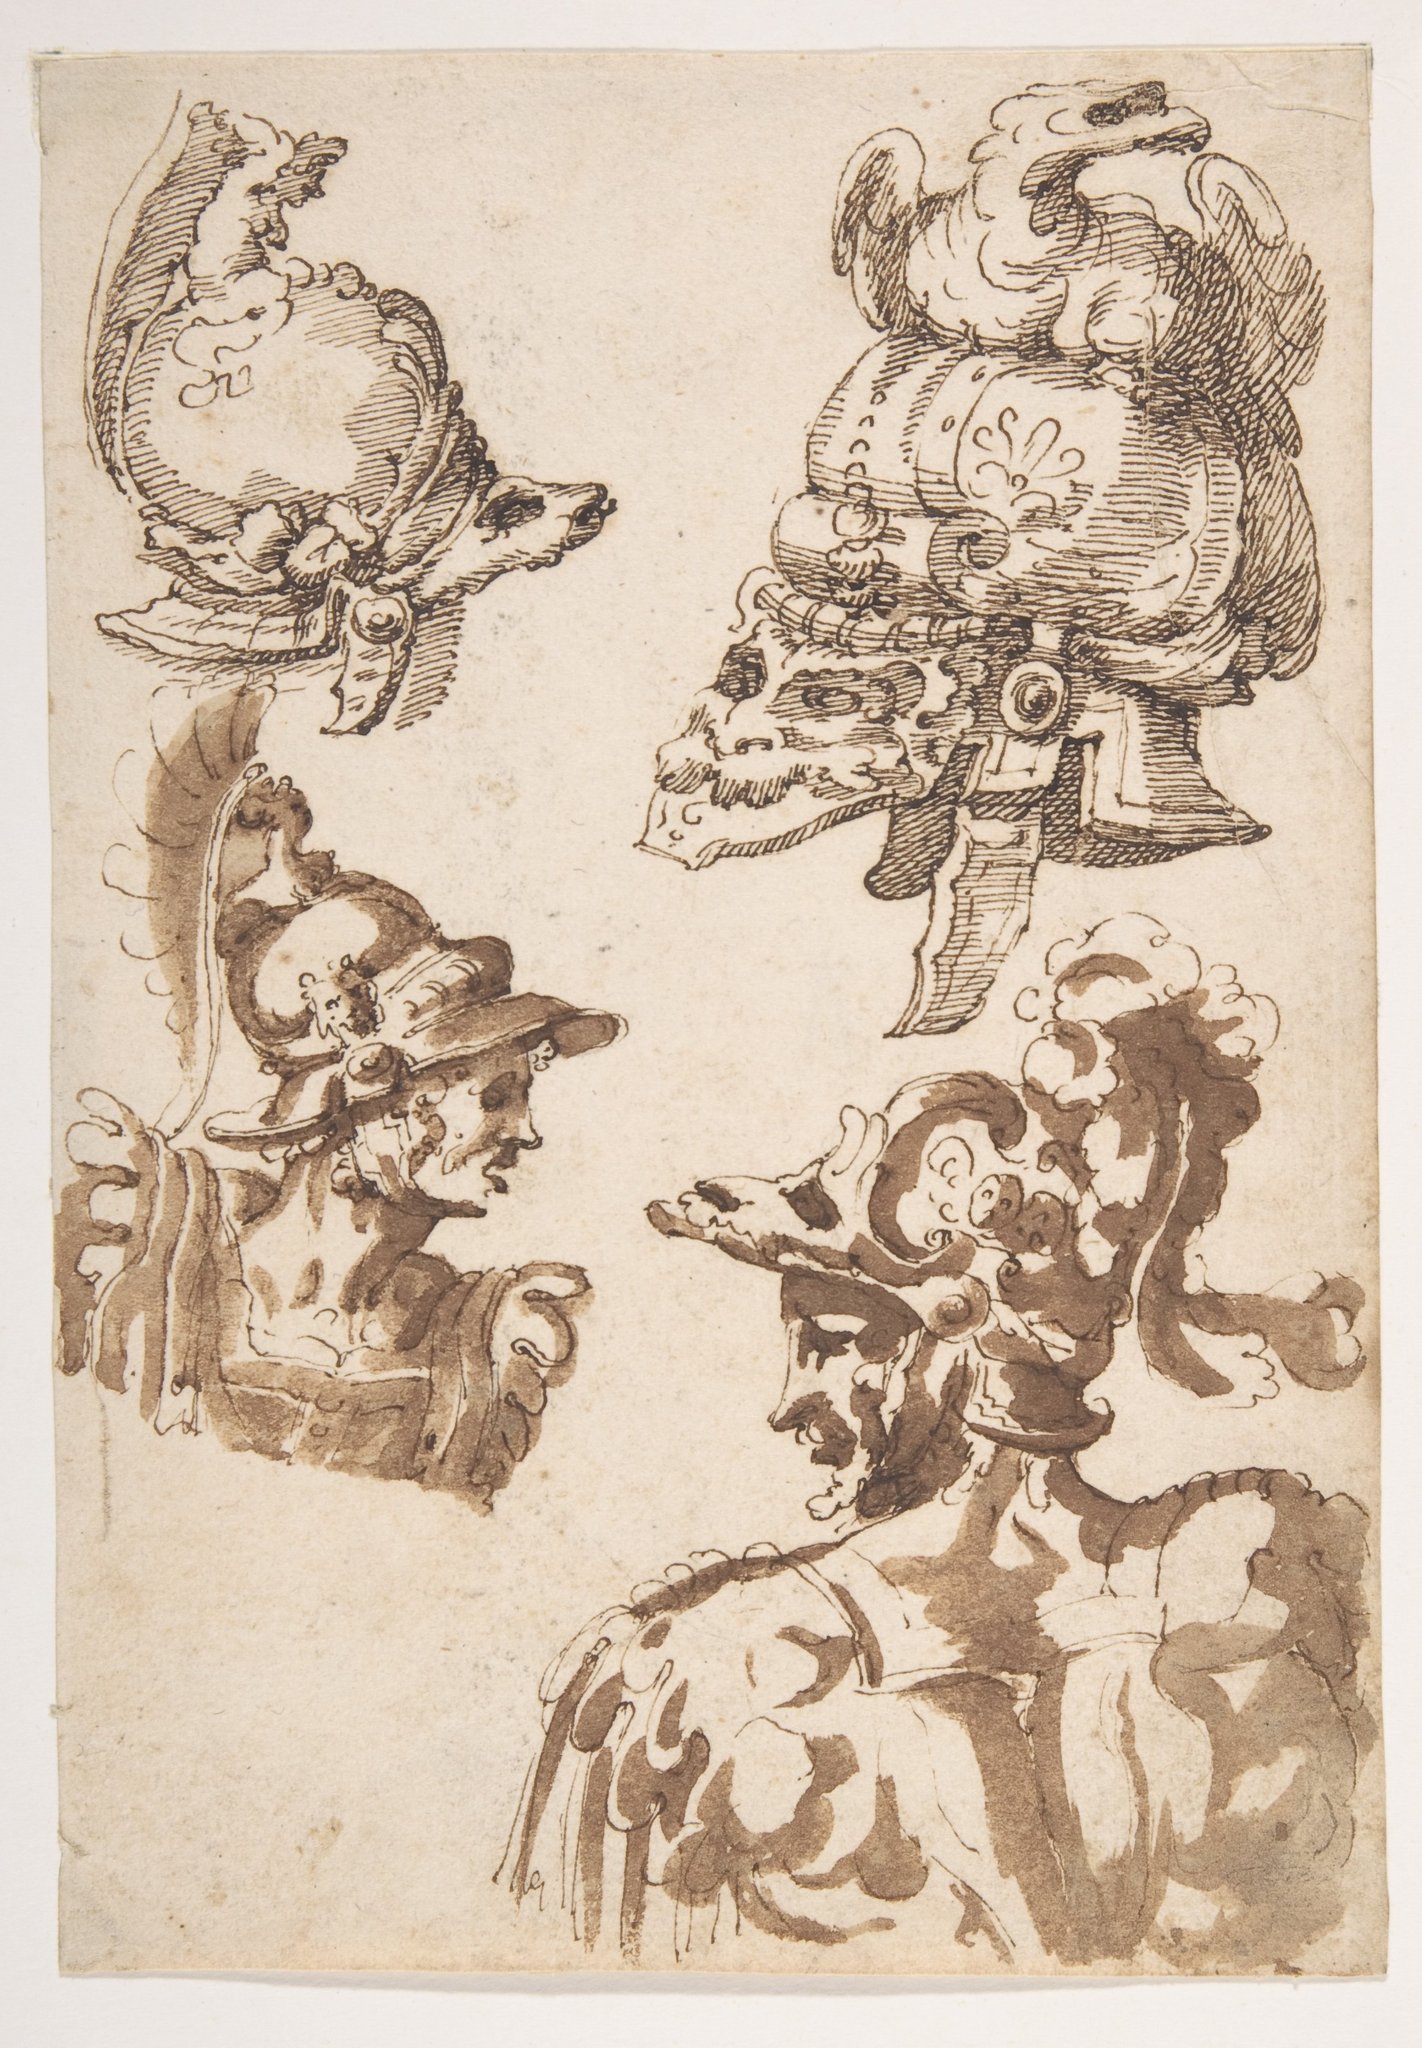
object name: drawing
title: Studies of Two Helmets and of Two Soldiers Wearing Helmets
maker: marco marchetti (marco da faenza)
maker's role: artist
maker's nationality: italian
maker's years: 1553-1588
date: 1553-1588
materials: ink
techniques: brush, pen, wash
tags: soldiers,helmets,men,profiles